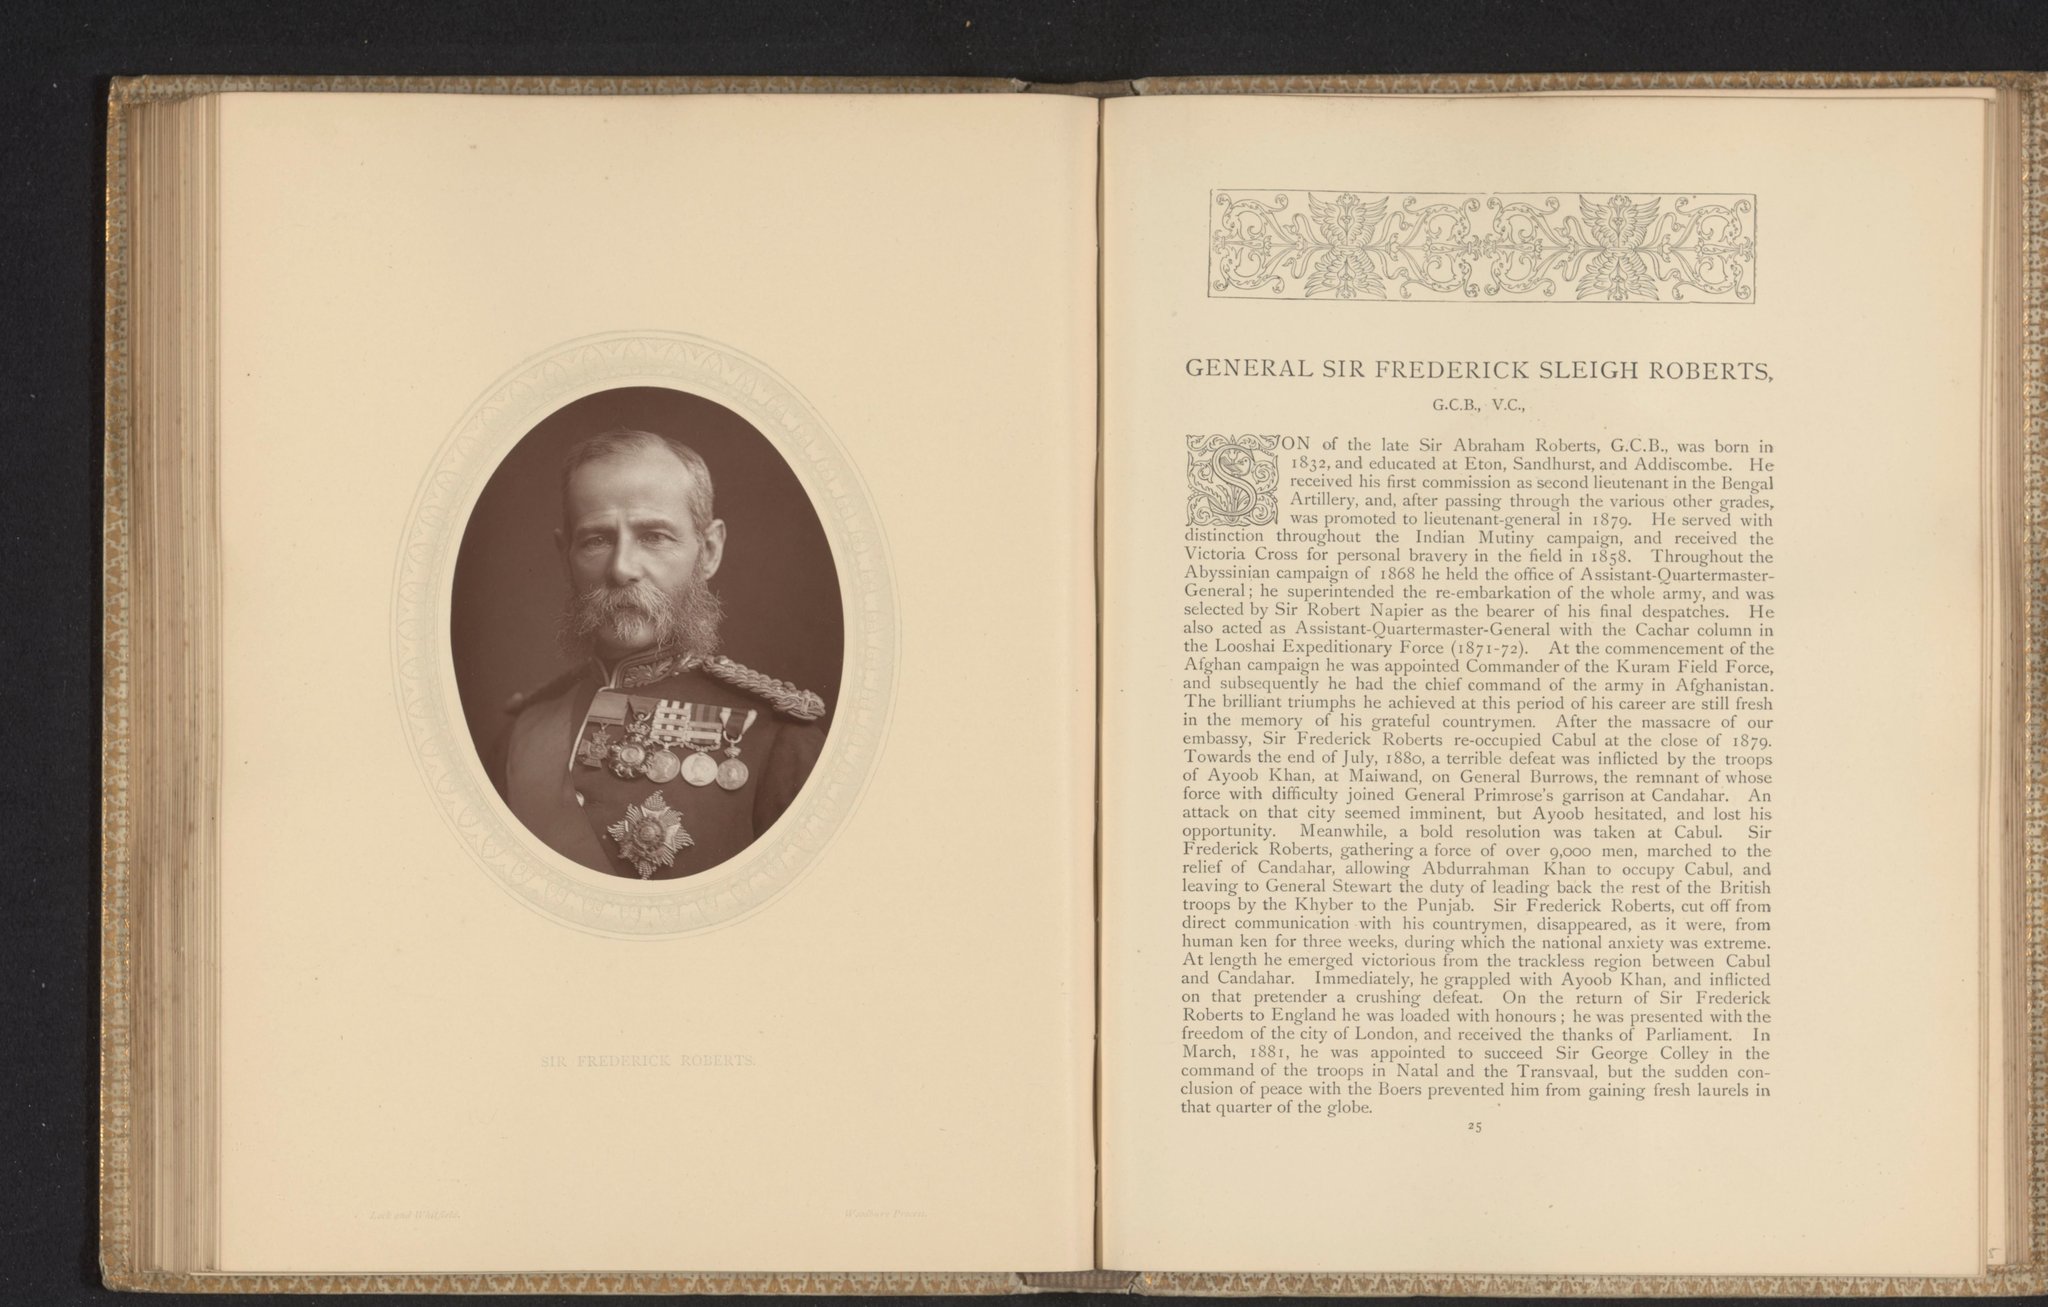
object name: photomechanical print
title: Sir Frederick Roberts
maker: Anonymous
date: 1877-1882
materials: paper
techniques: woodburytype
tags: commander-in-chief, general, marshal, historical persons (portraits and scenes from the life) (+ (full) bust portrait)